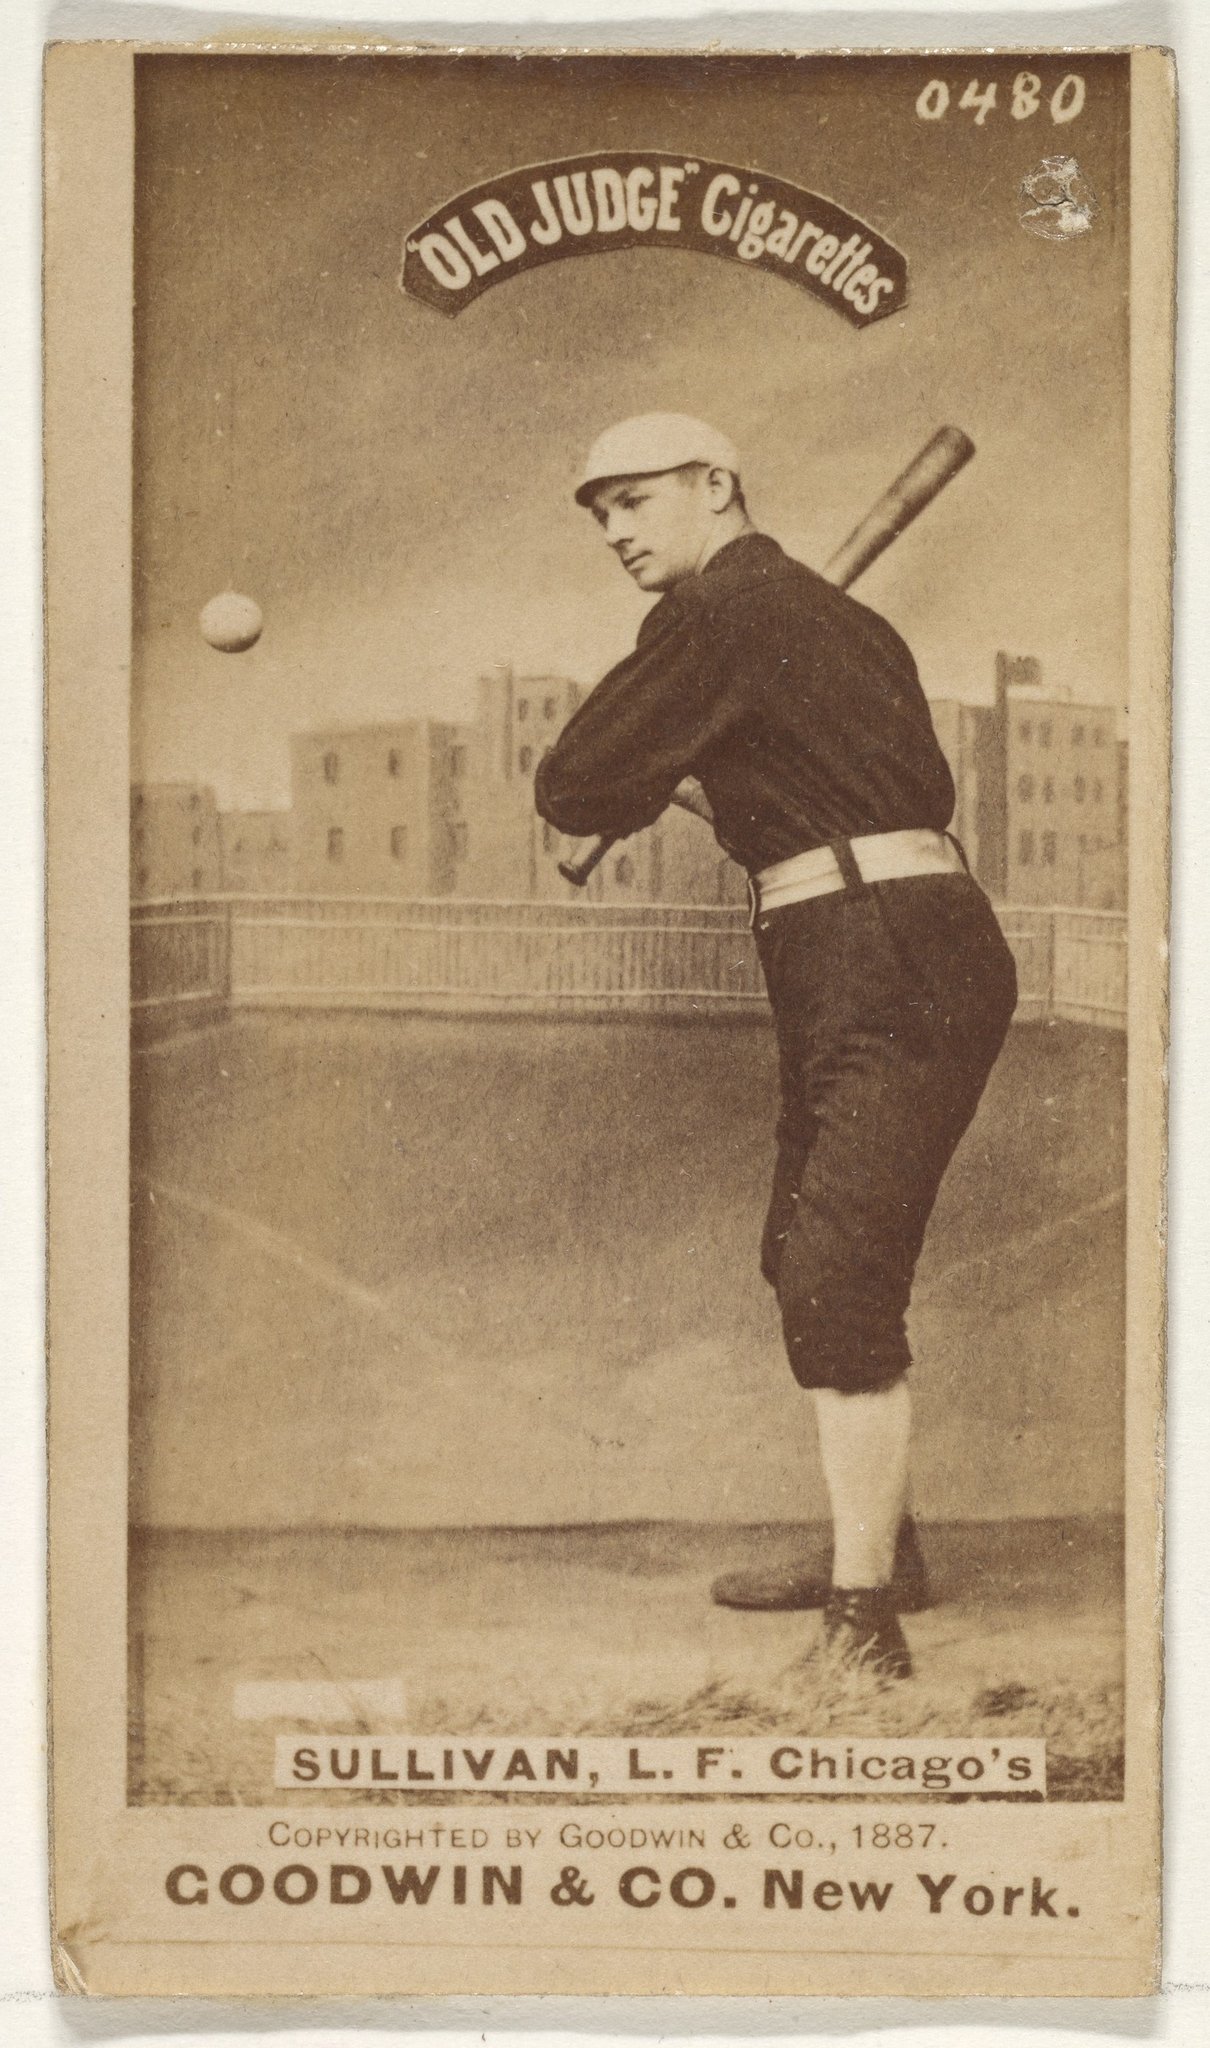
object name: baseball card, photograph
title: Sullivan, Left Field, Chicago, from the Old Judge series (N172) for Old Judge Cigarettes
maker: goodwin & company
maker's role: publisher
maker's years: 1850-1950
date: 1887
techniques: albumen silver print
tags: men,portraits,baseball,athletes